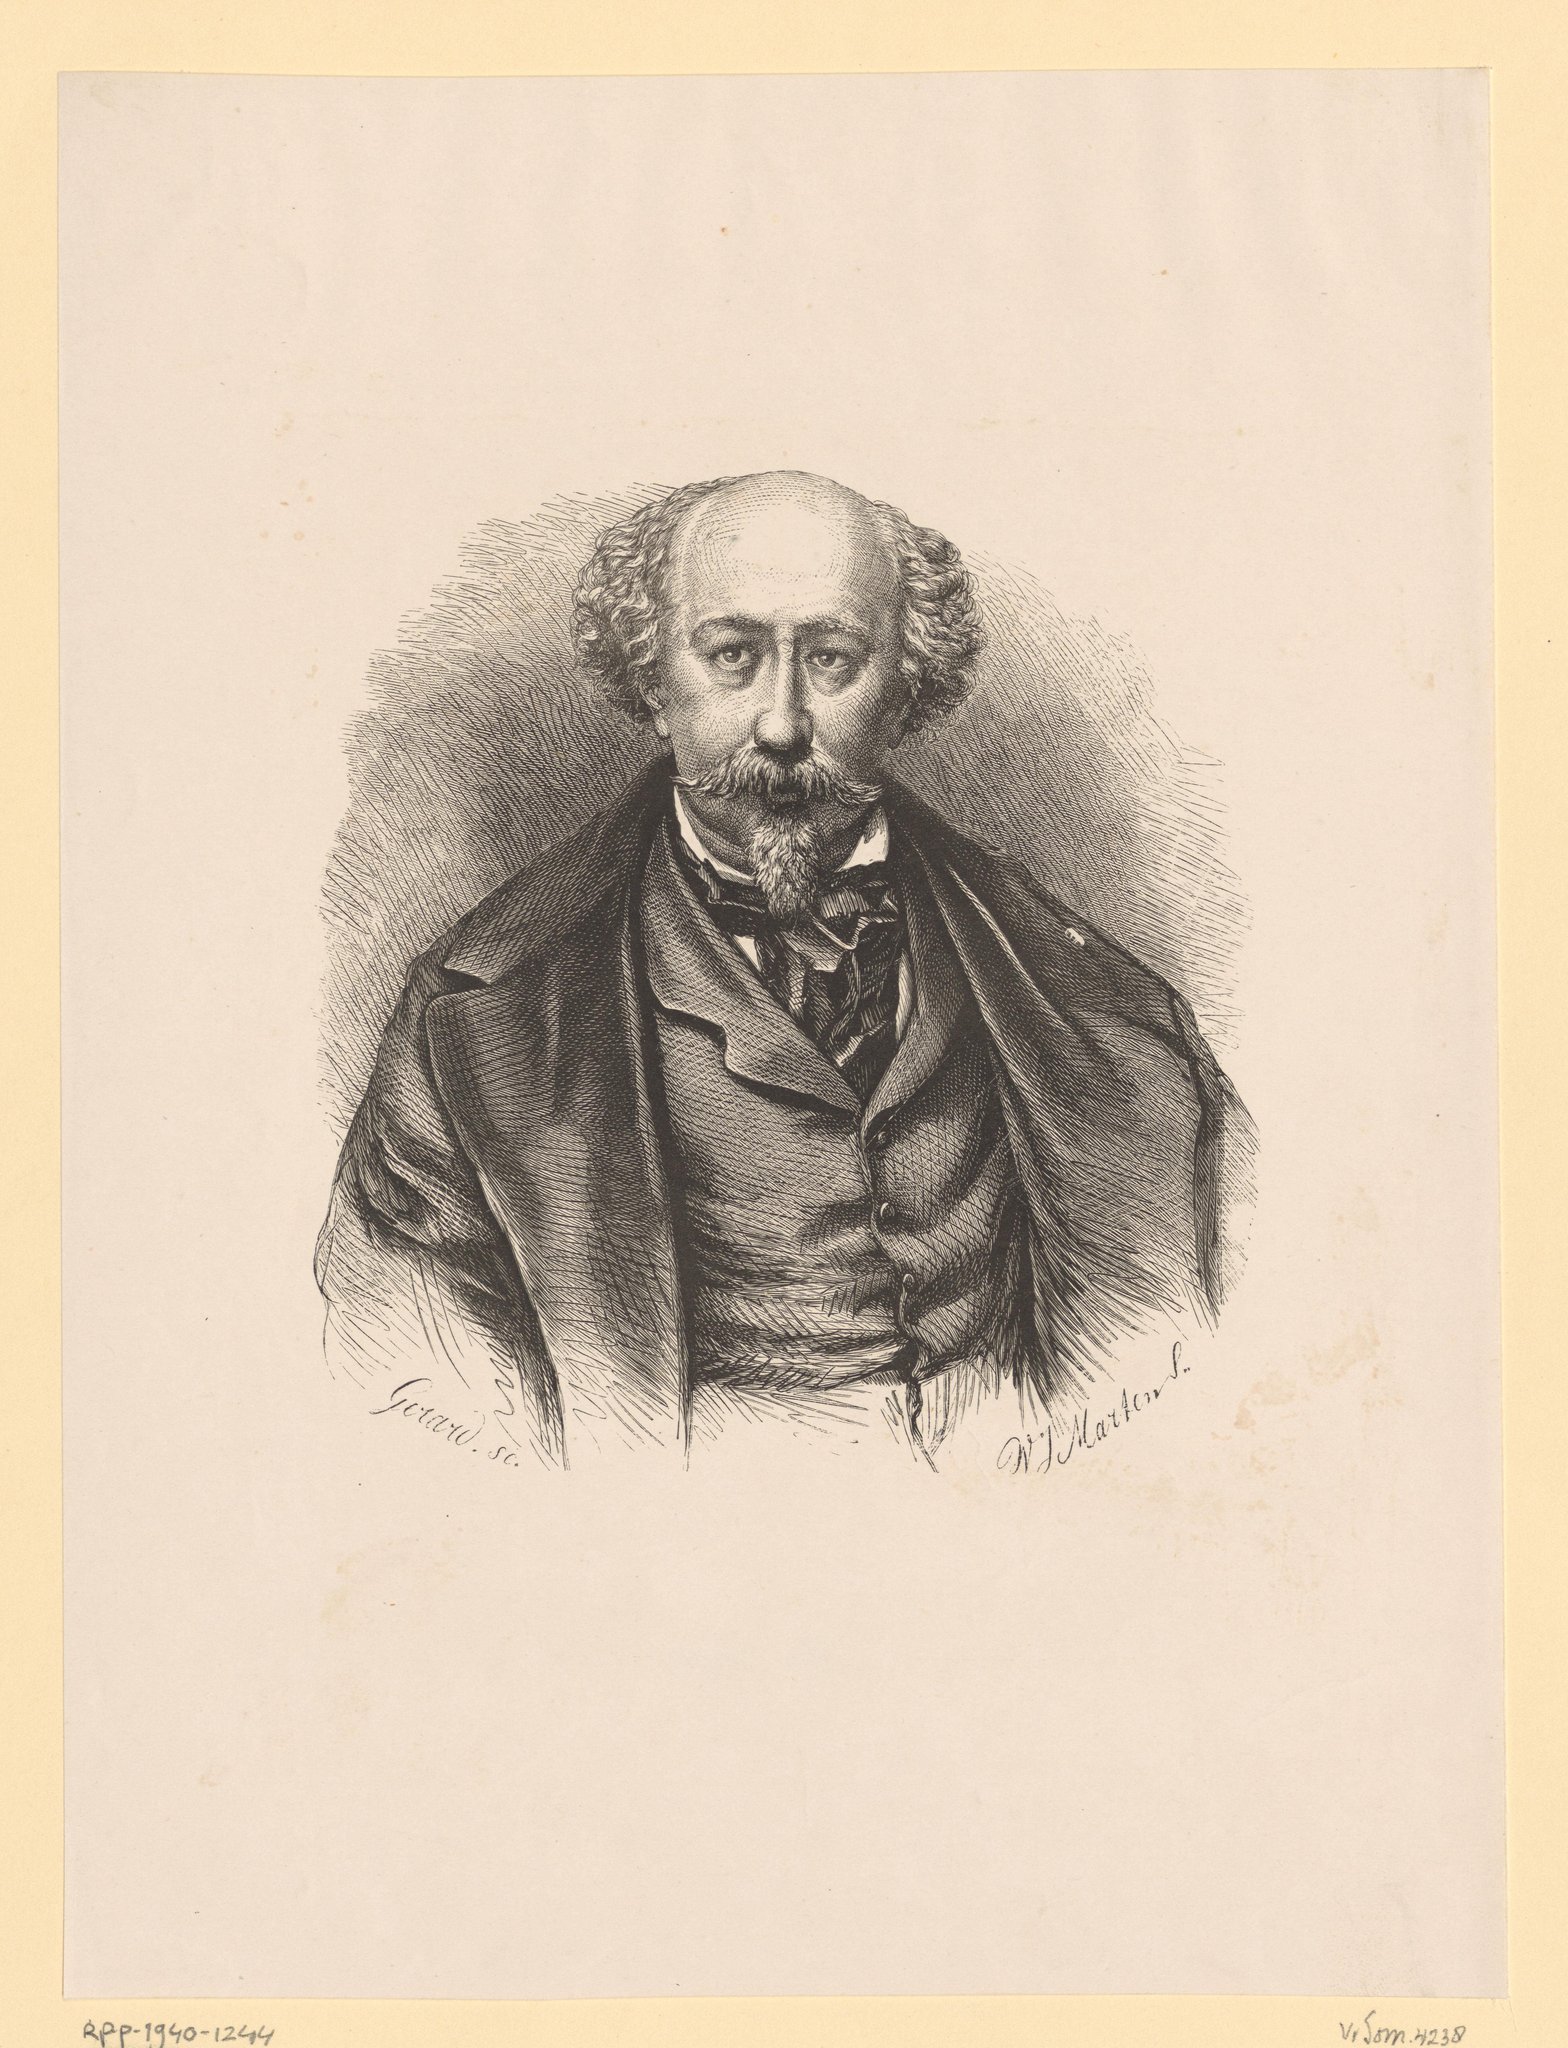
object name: print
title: Portret van Nicolaas Pieneman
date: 1861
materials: paper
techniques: engraving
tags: amsterdam, painter, print maker, nicolaas pieneman, historical persons, old man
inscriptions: collector's mark: Lugt 2760, collector's mark: Lugt 2228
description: Prent met tekst op verso gebruikt in: Nederlandsch Magazijn 56 (1861).